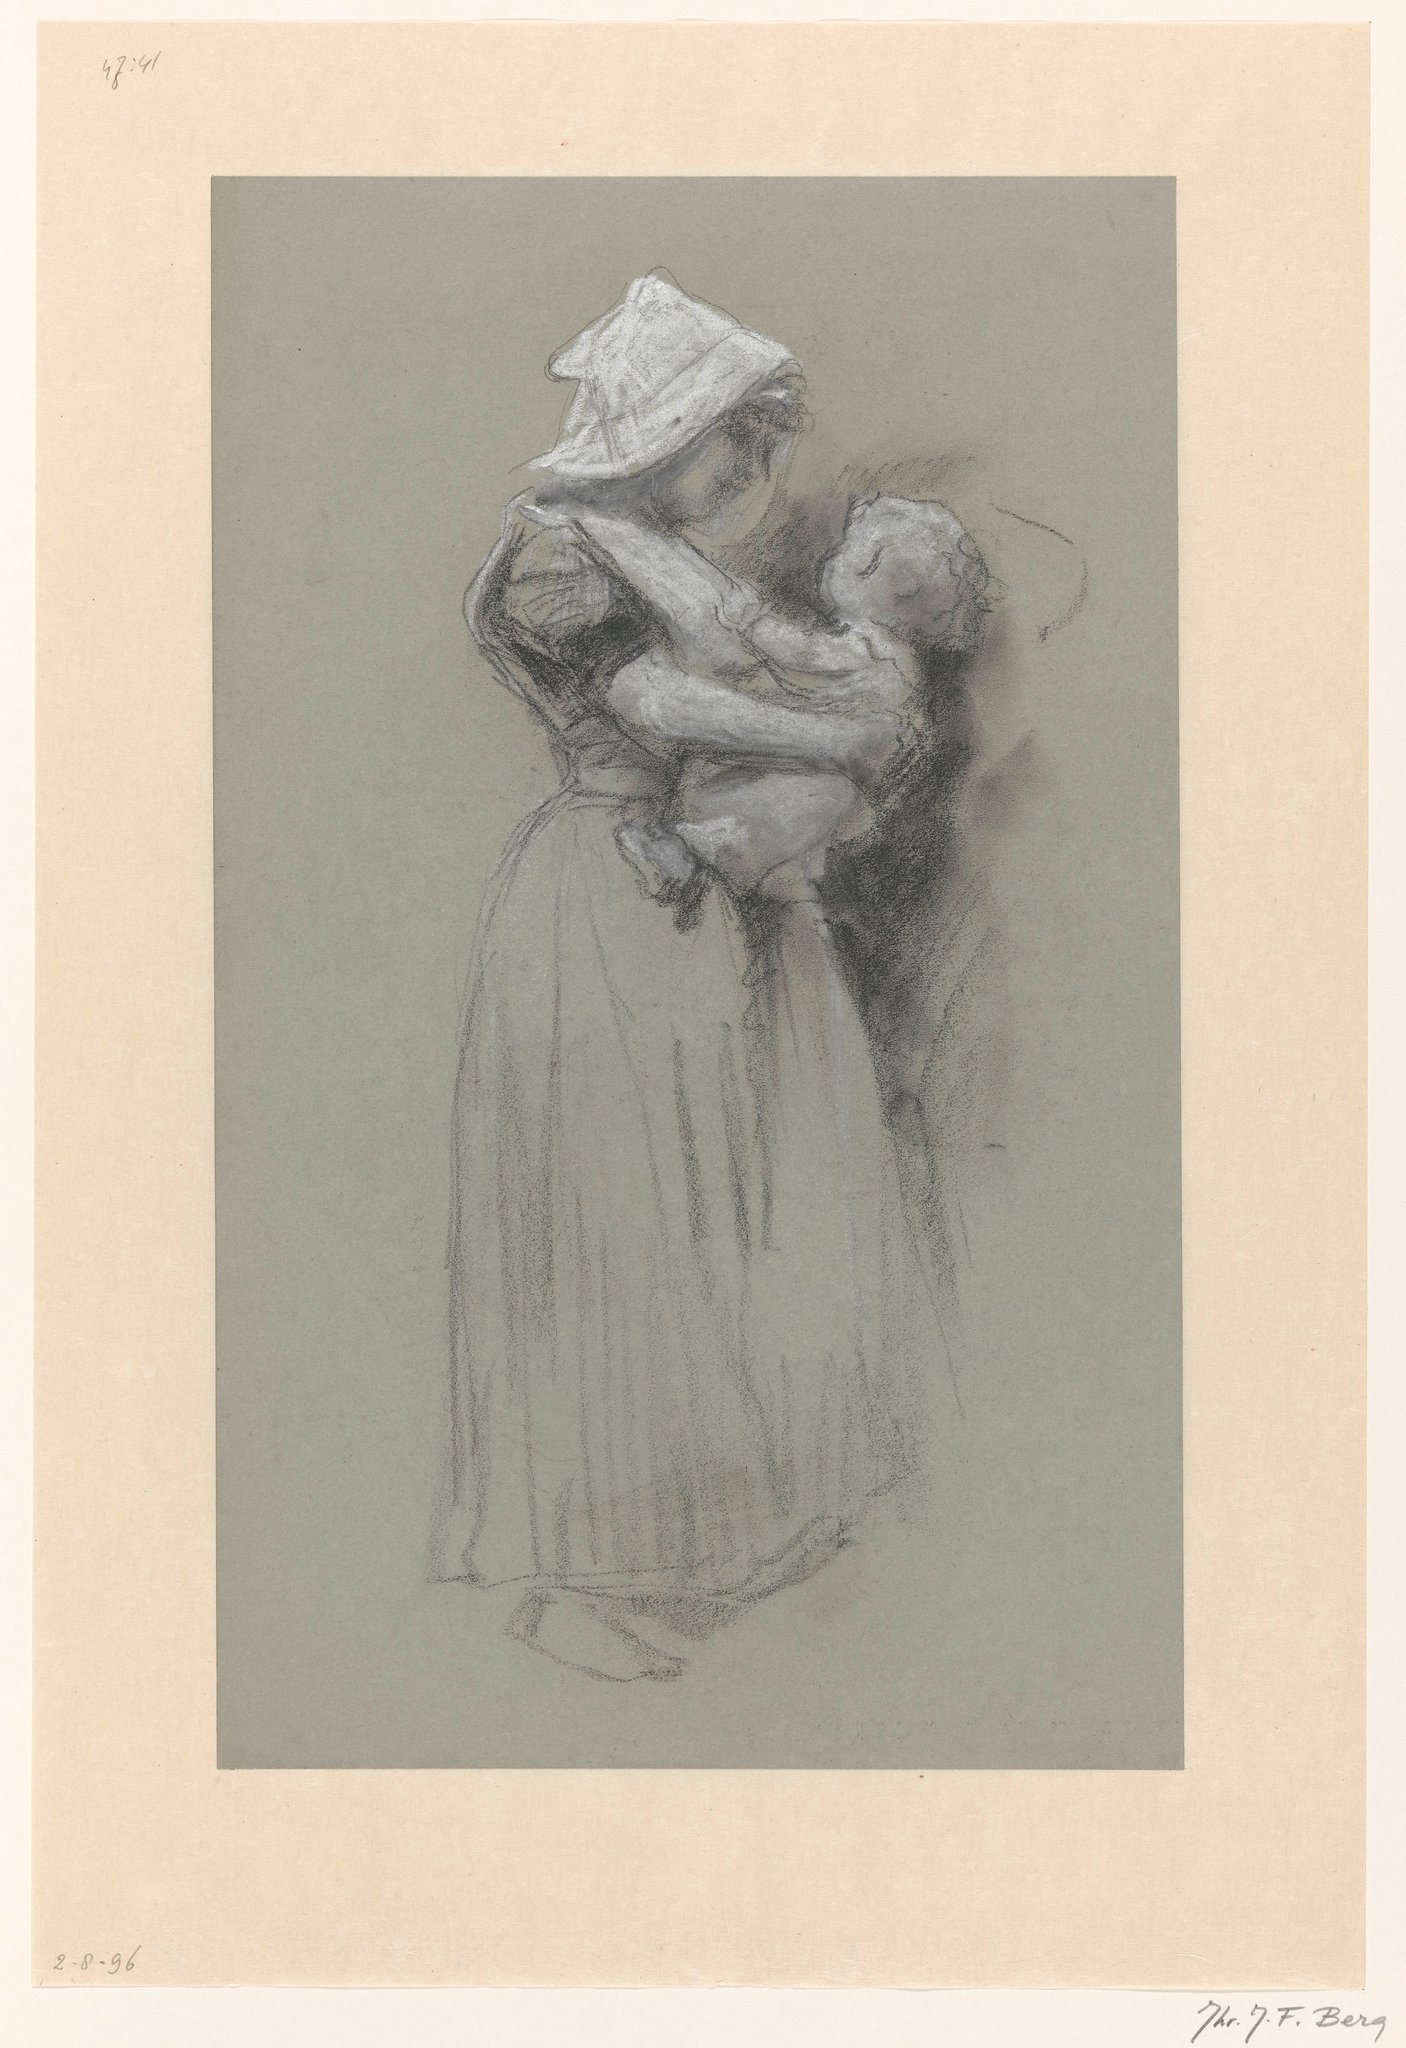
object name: drawing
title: Studie van een Zeeuwse boerin met een kind op de arm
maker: joan berg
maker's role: draughtsman, print maker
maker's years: 1851-1935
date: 1861-1935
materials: chalk, paper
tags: folk costume, regional costume, zeeland